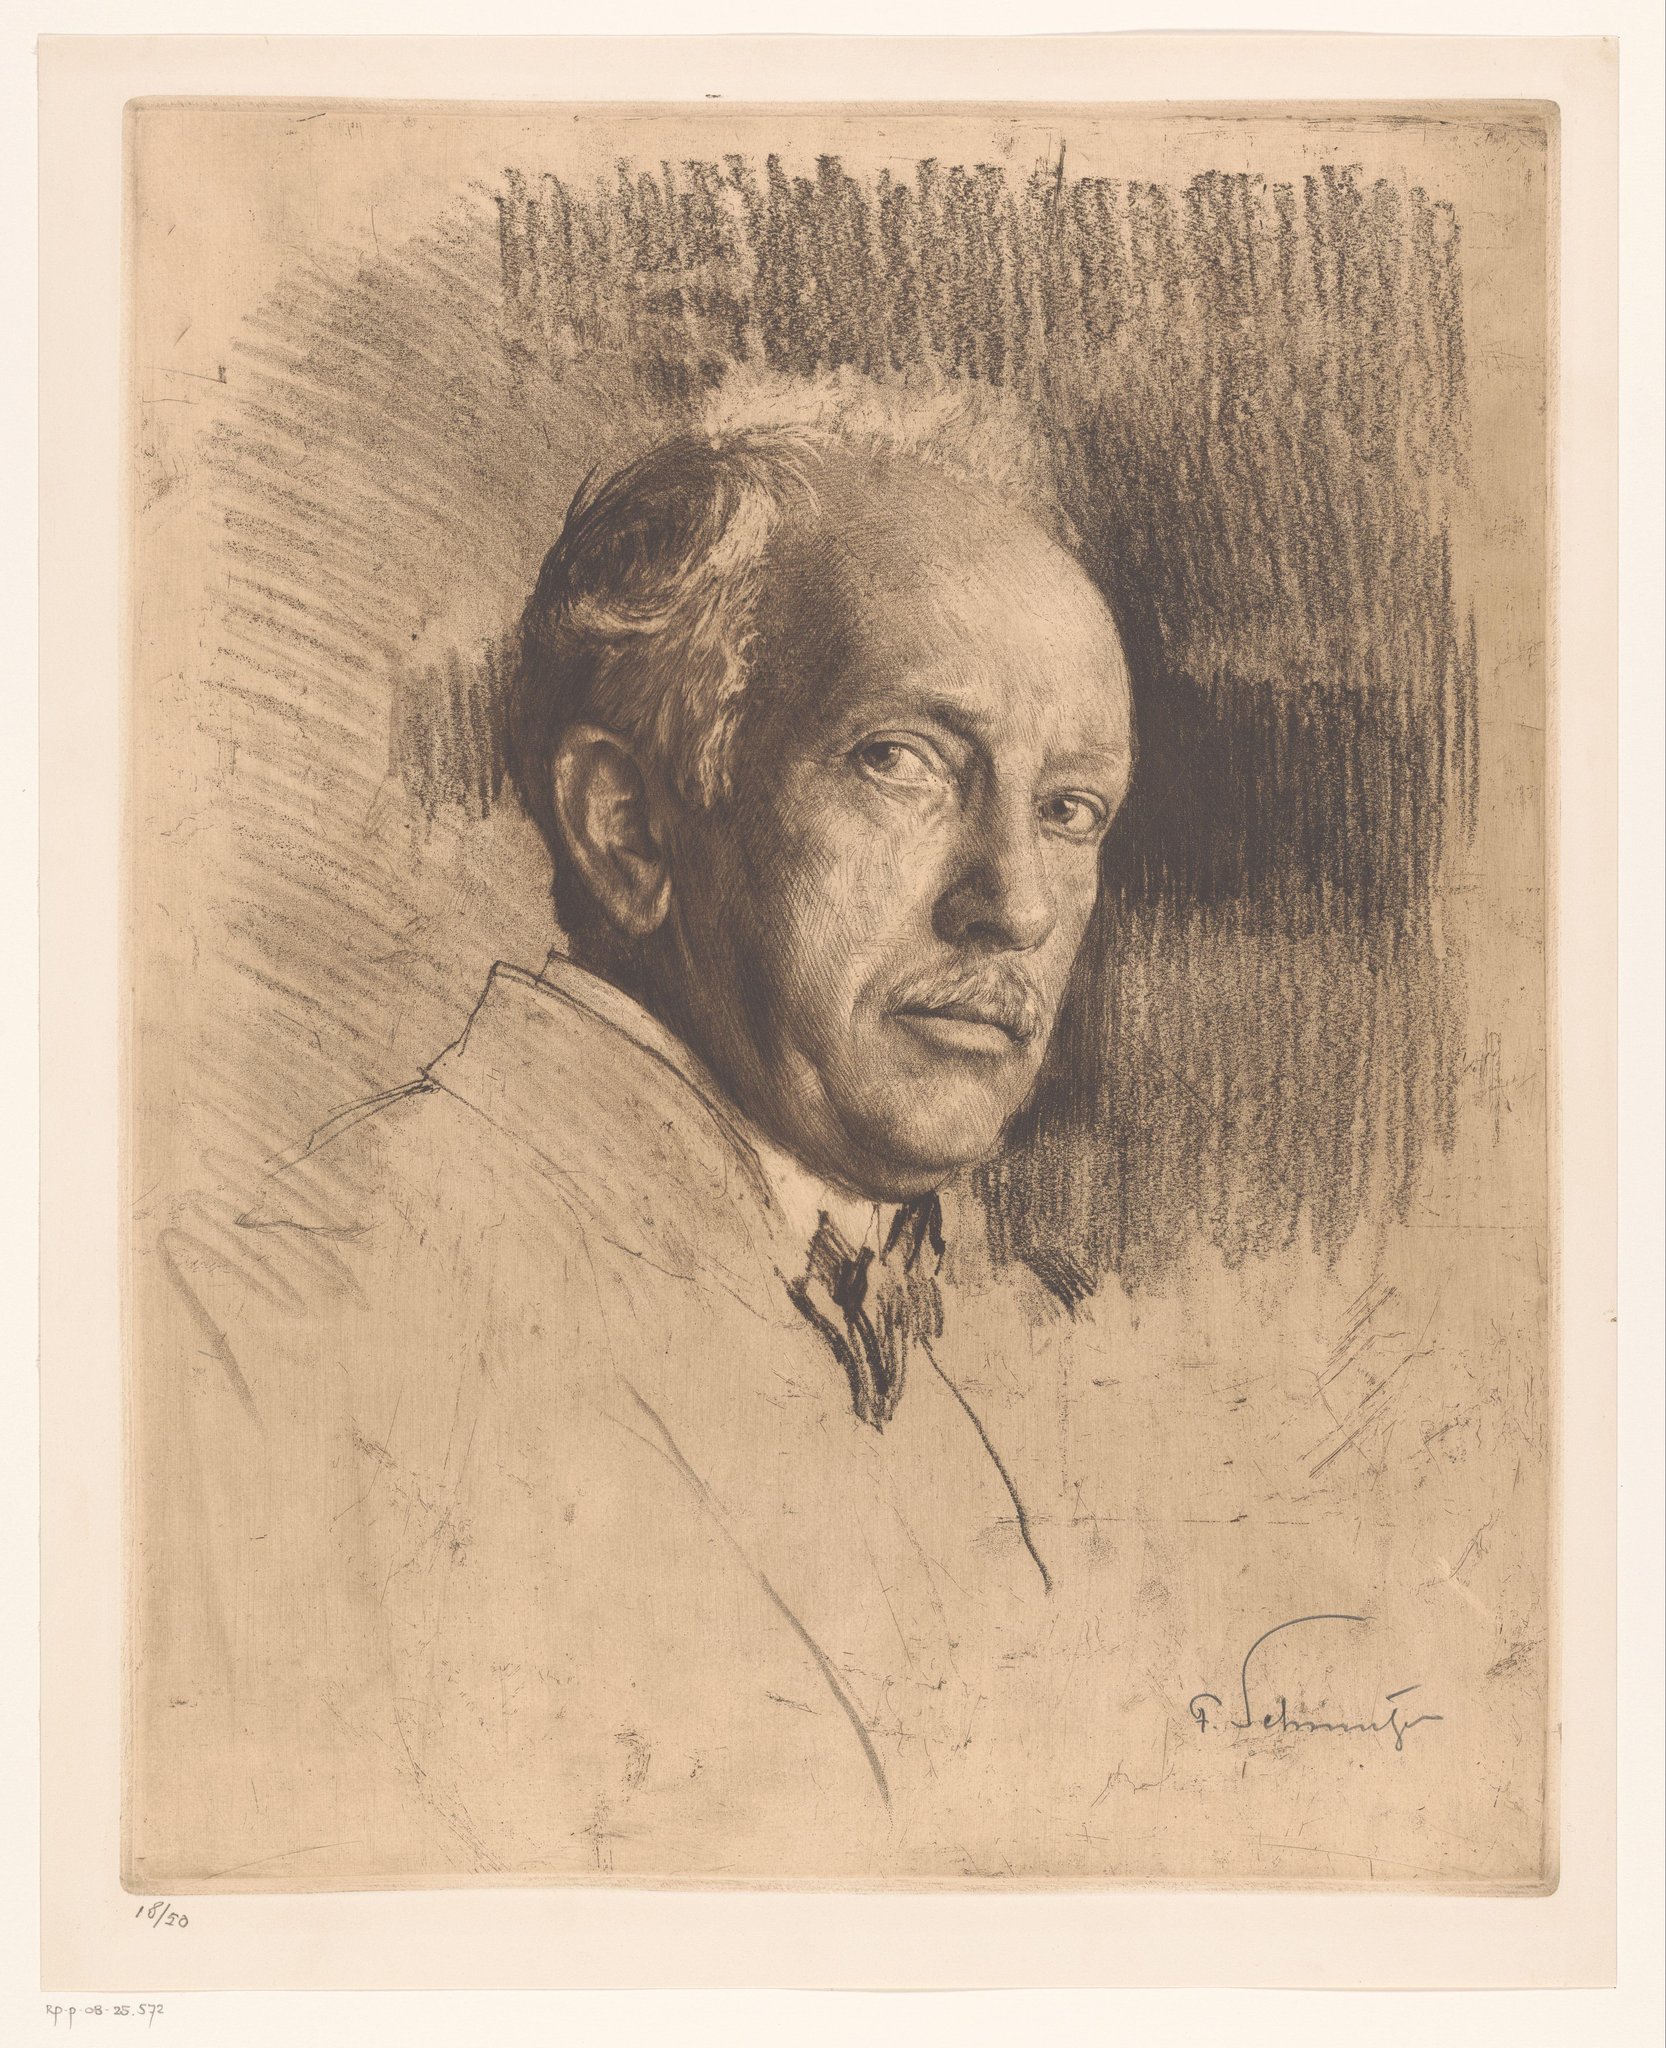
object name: print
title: Portret van Richard Strauss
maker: ferdinand schmutzer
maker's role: painter, print maker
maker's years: 1870-1928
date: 1925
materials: paper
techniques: etching, intaglio, soft ground etching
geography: vienna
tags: portrait of composer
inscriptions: collector's mark: Lugt 2228